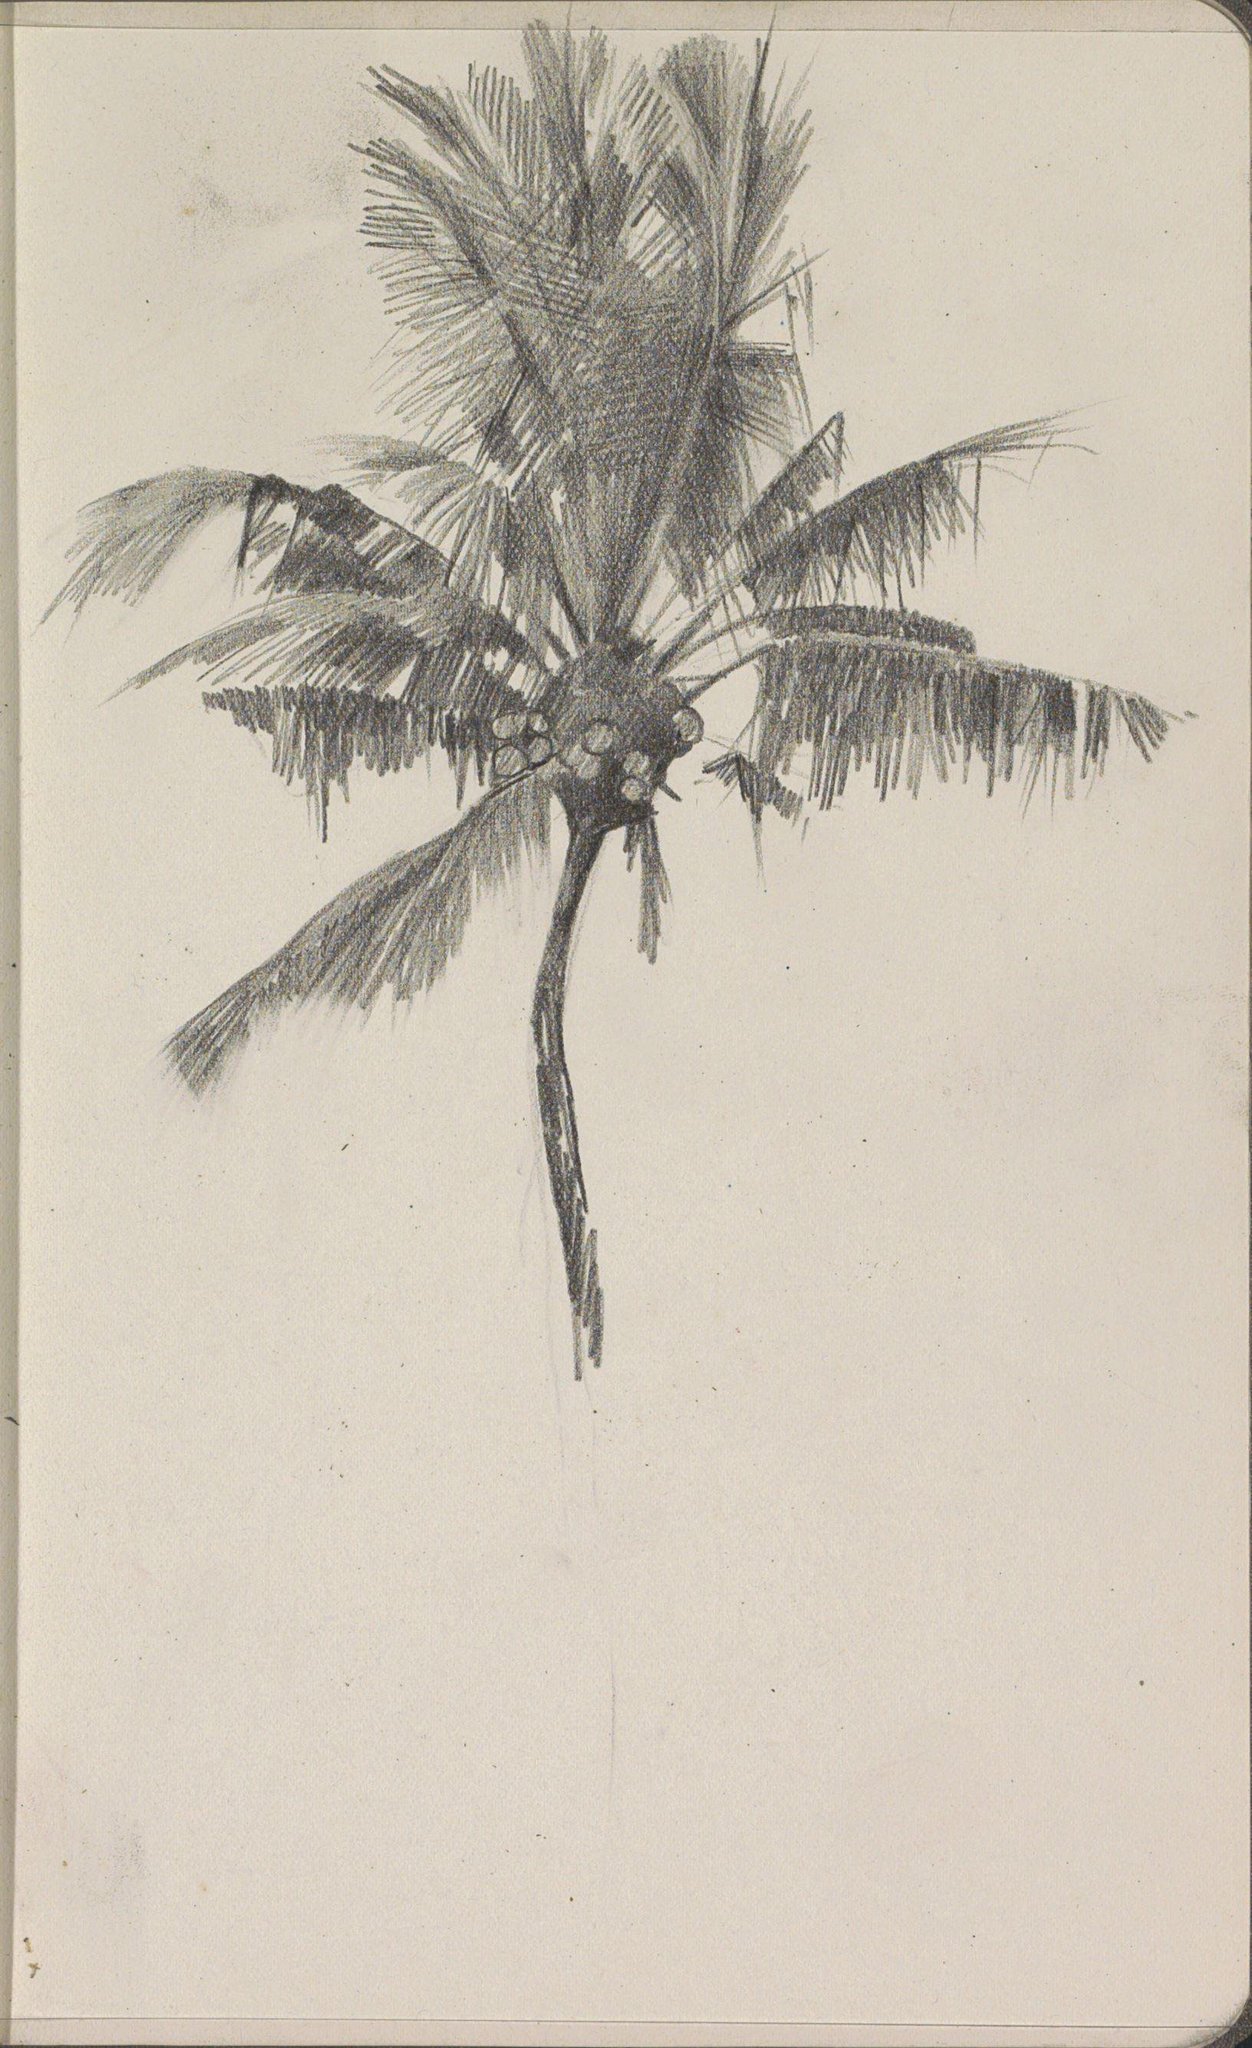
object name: sketchbook leaf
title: Palmboom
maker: willem witsen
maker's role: draughtsman, painter, print maker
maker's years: 1860-1923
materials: paper, pencil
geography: dutch east indies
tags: trees: palm-tree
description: Blad 10 uit een schetsboek met 75 bladen vervaardigd te Nederlands-Indië.